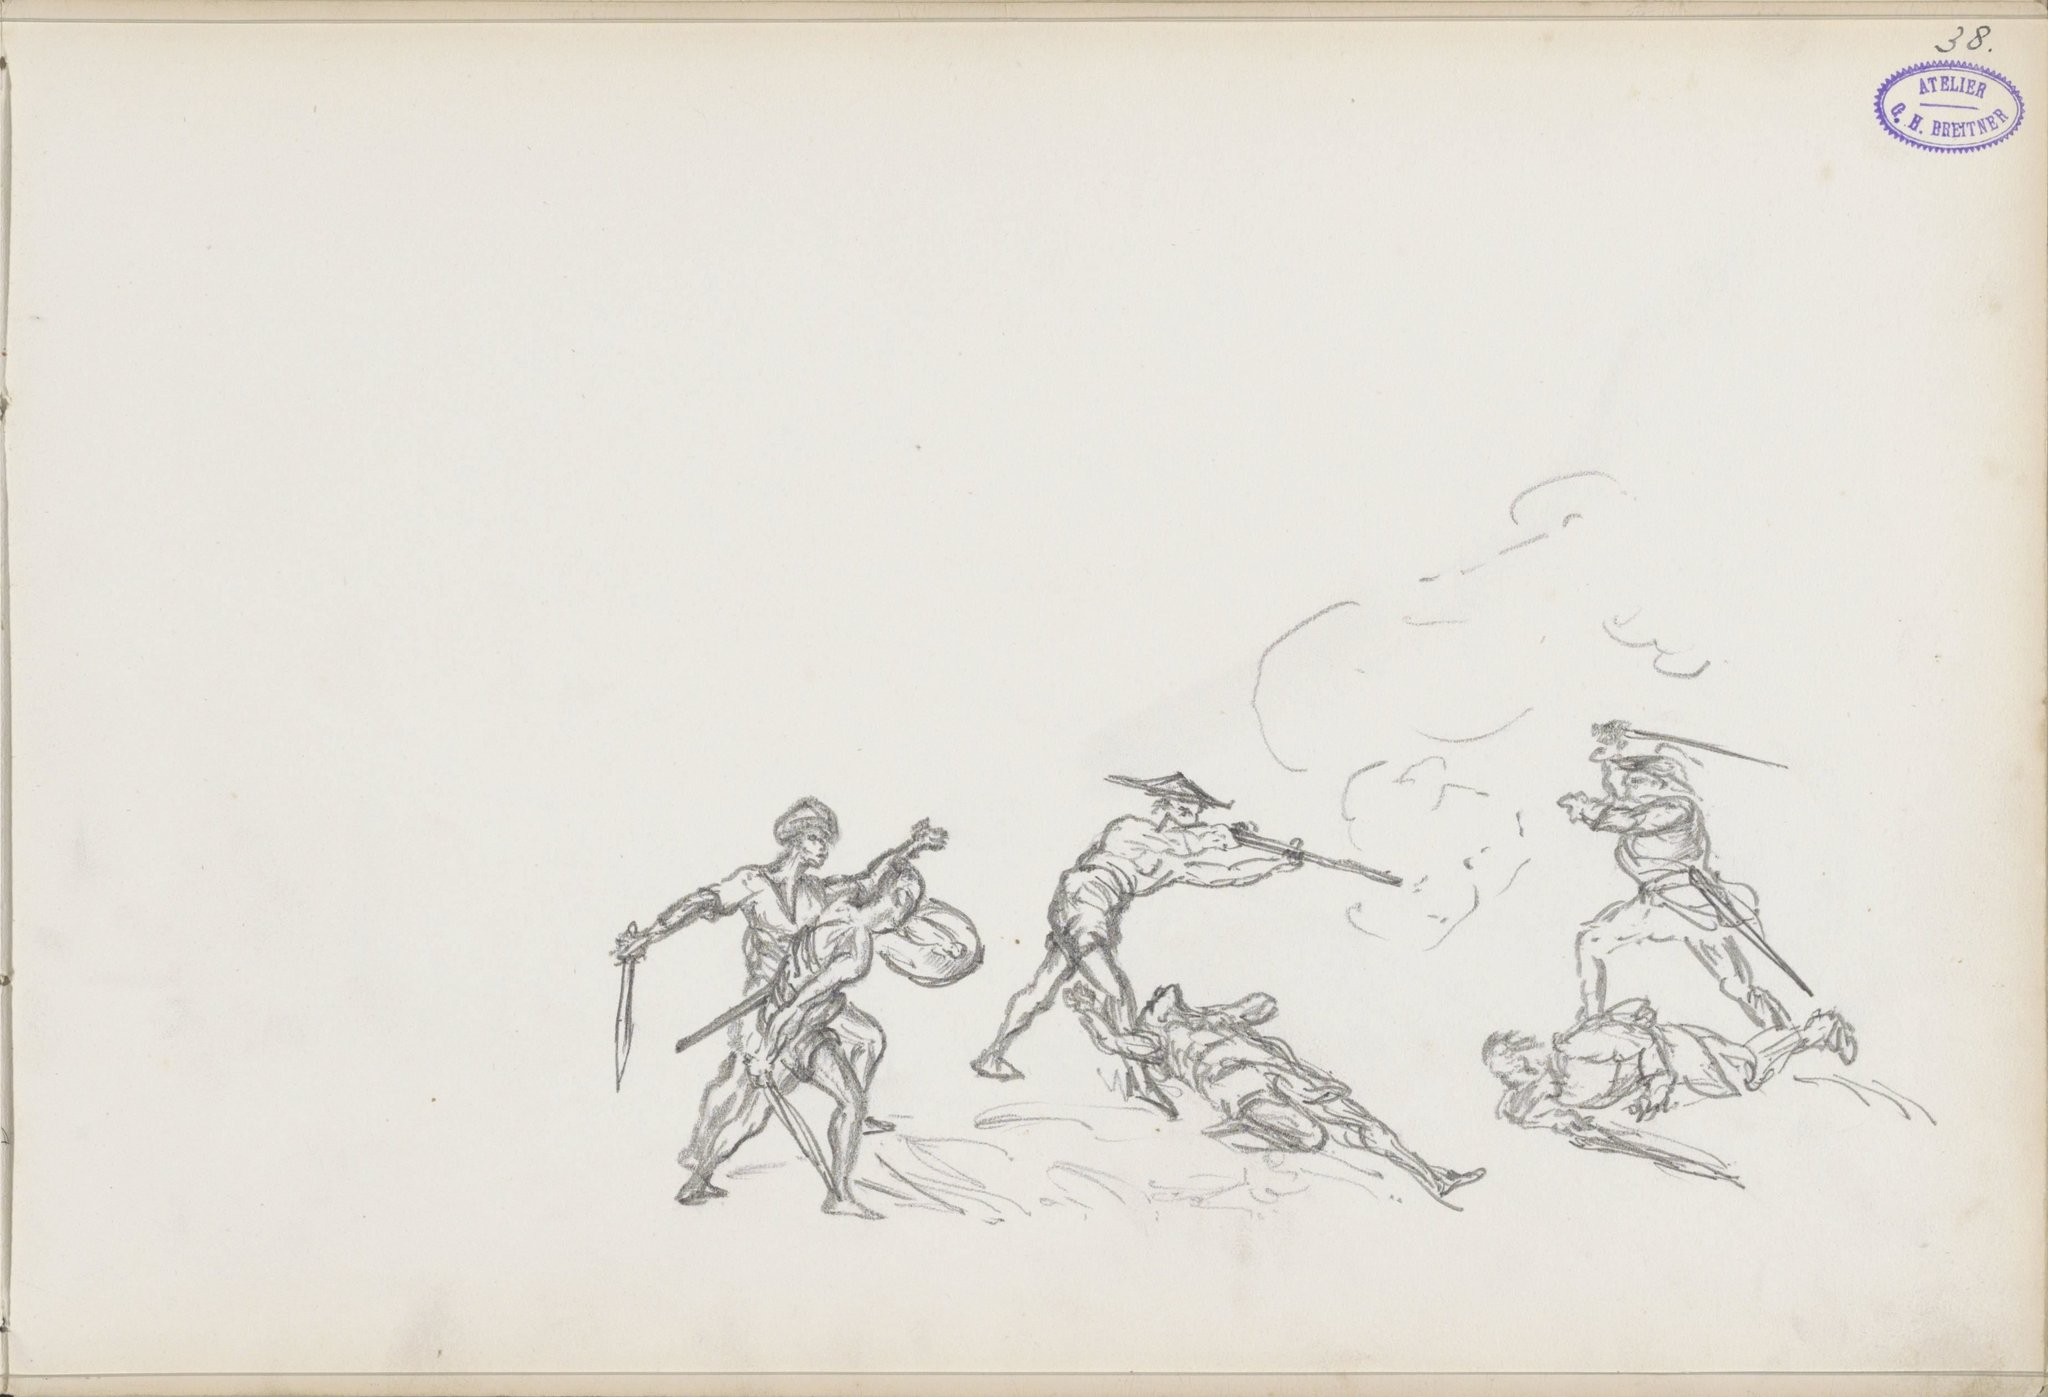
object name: sketchbook leaf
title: Vechtende mannen met schilden, zwaarden en geweren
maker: george hendrik breitner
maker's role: draughtsman, painter, print maker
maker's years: 1857-1923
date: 1809-1872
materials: paper, pencil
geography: rotterdam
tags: division of armed forces (+ during the battle)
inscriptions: workshop stamp: Lugt 291d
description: Blad 38 recto uit een schetsboek met 32 bladen.